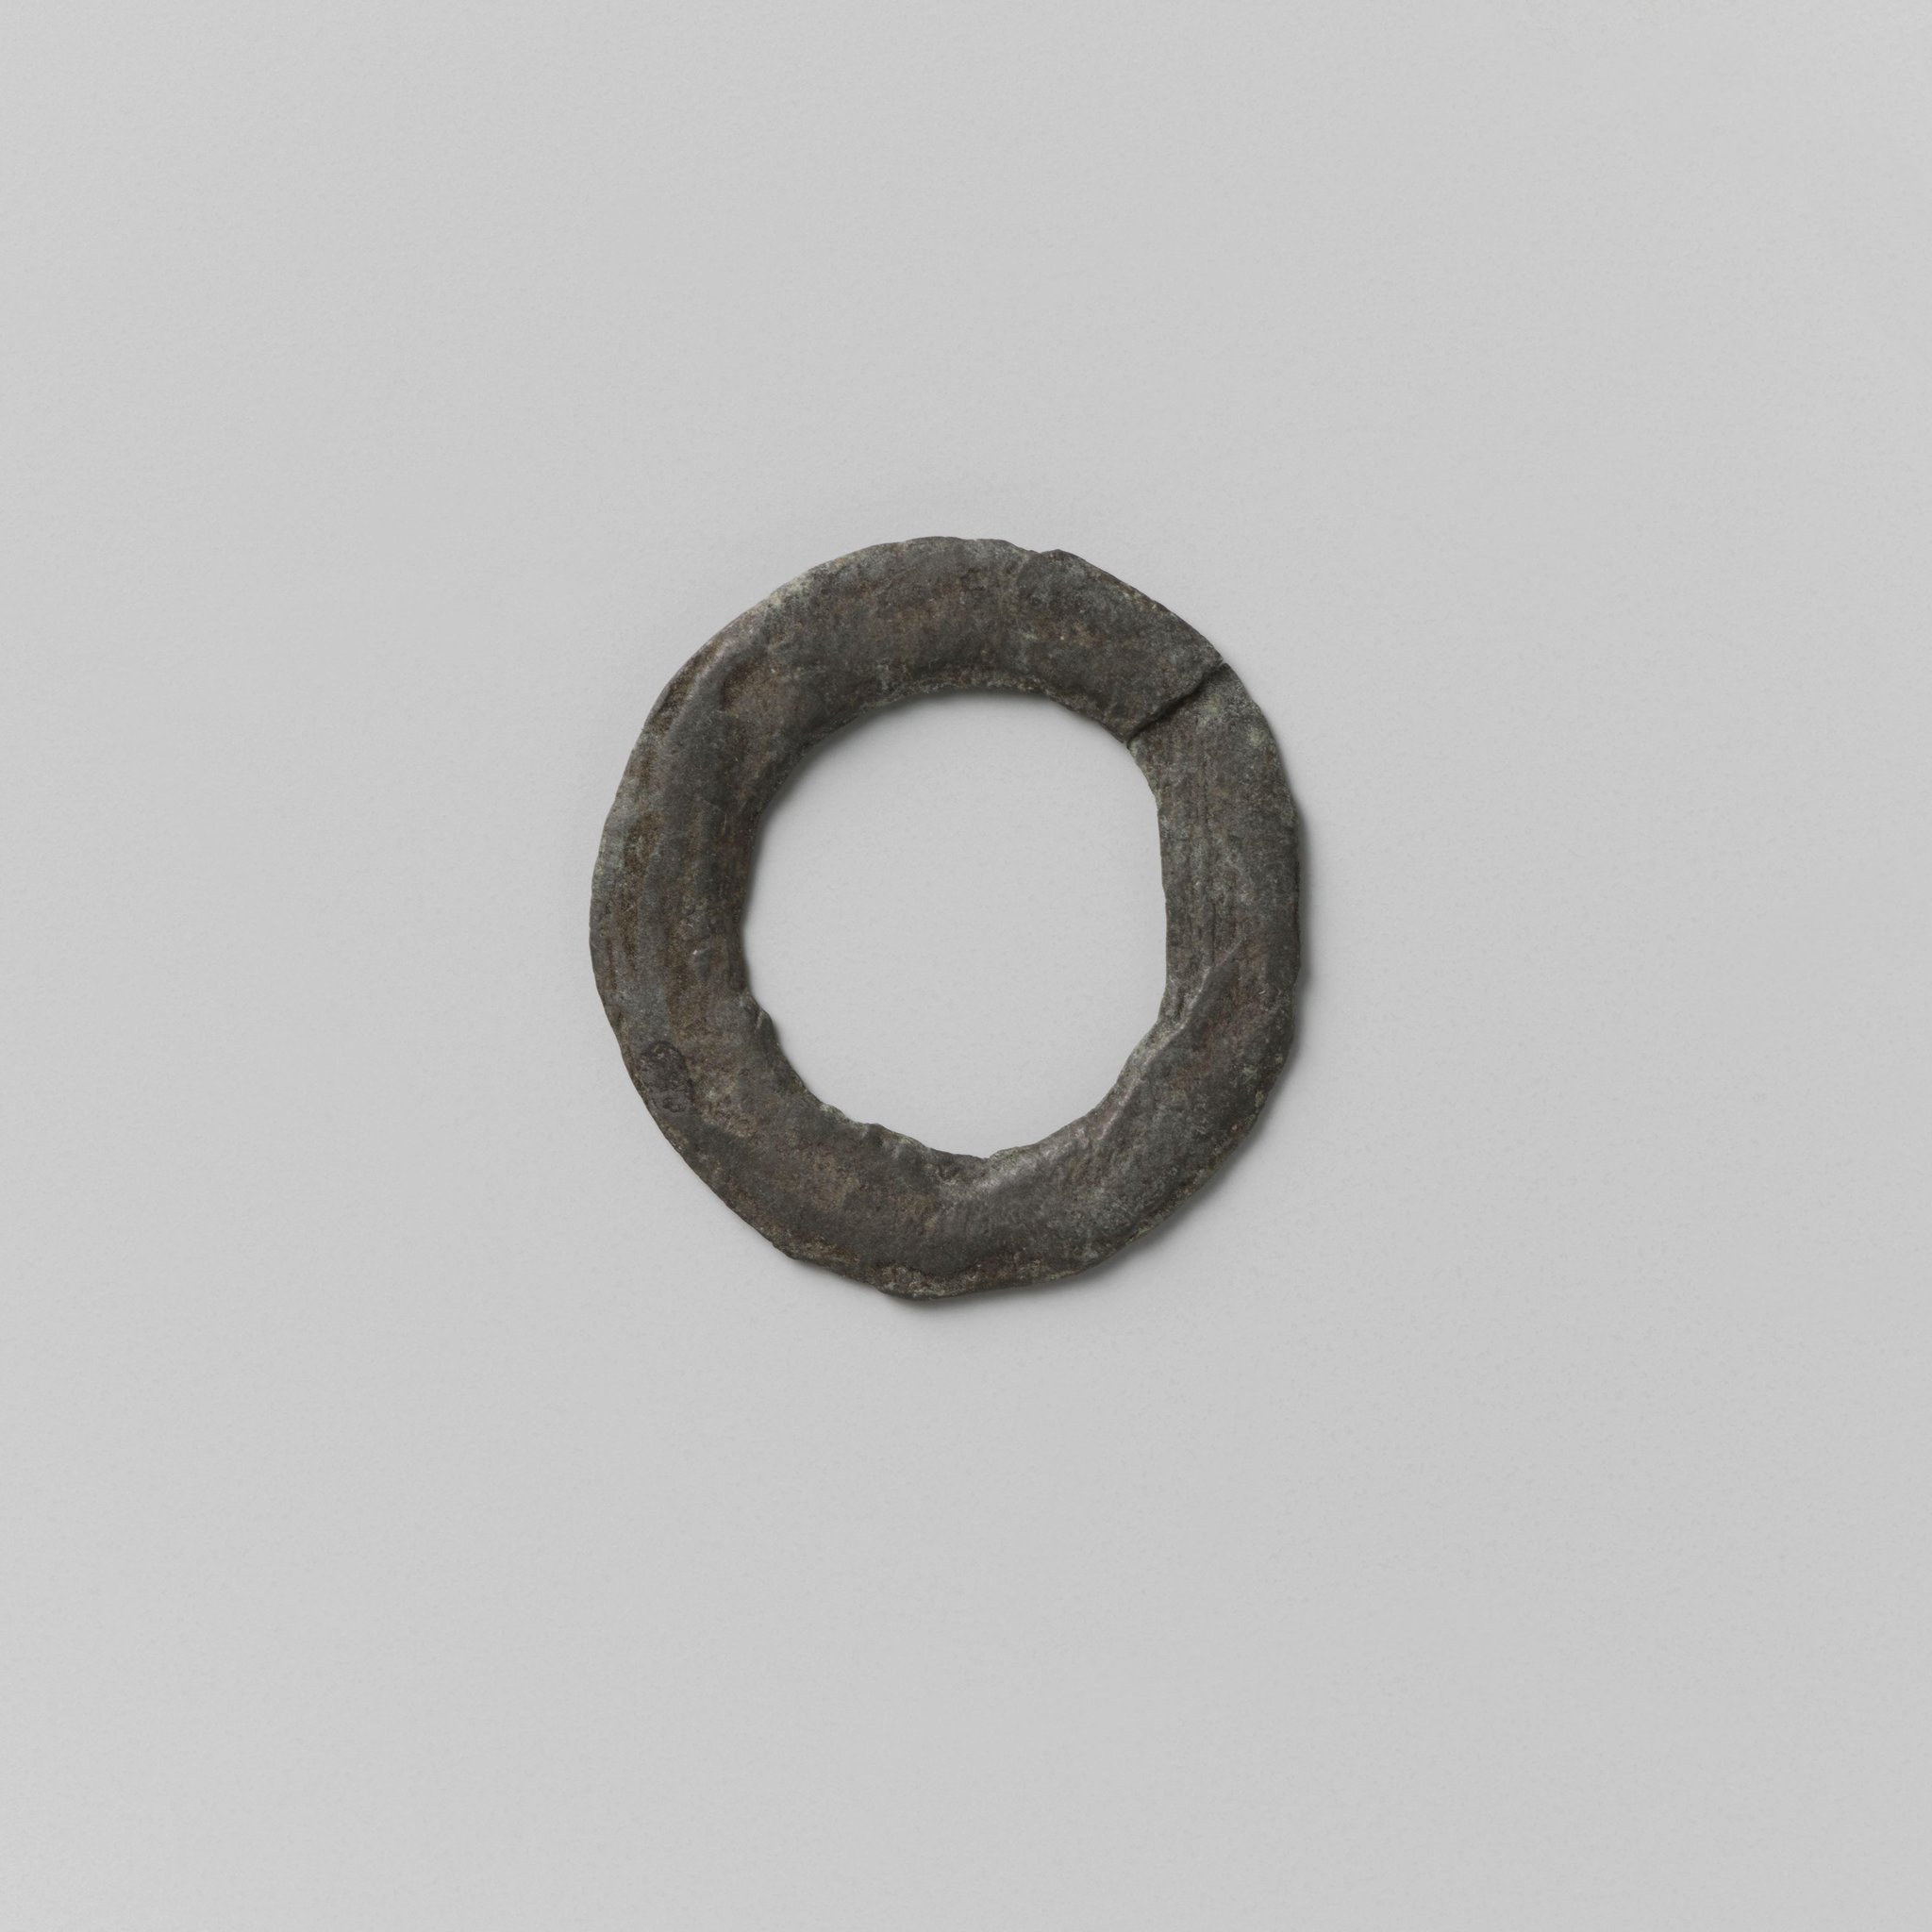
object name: coin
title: Pitji van sultan Mamoed Bader ed-din II van Palembang, Sumatra, AH 1219 (1804)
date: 1798-1821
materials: tin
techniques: casting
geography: palembang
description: Tinnen achthoekige munt. Voorzijde: zonder omschrift. Keerzijde, glad. In het midden rond gat.